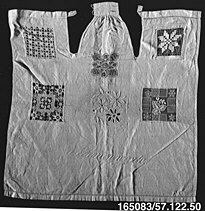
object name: sampler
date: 1801-1900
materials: cotton, linen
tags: flowers